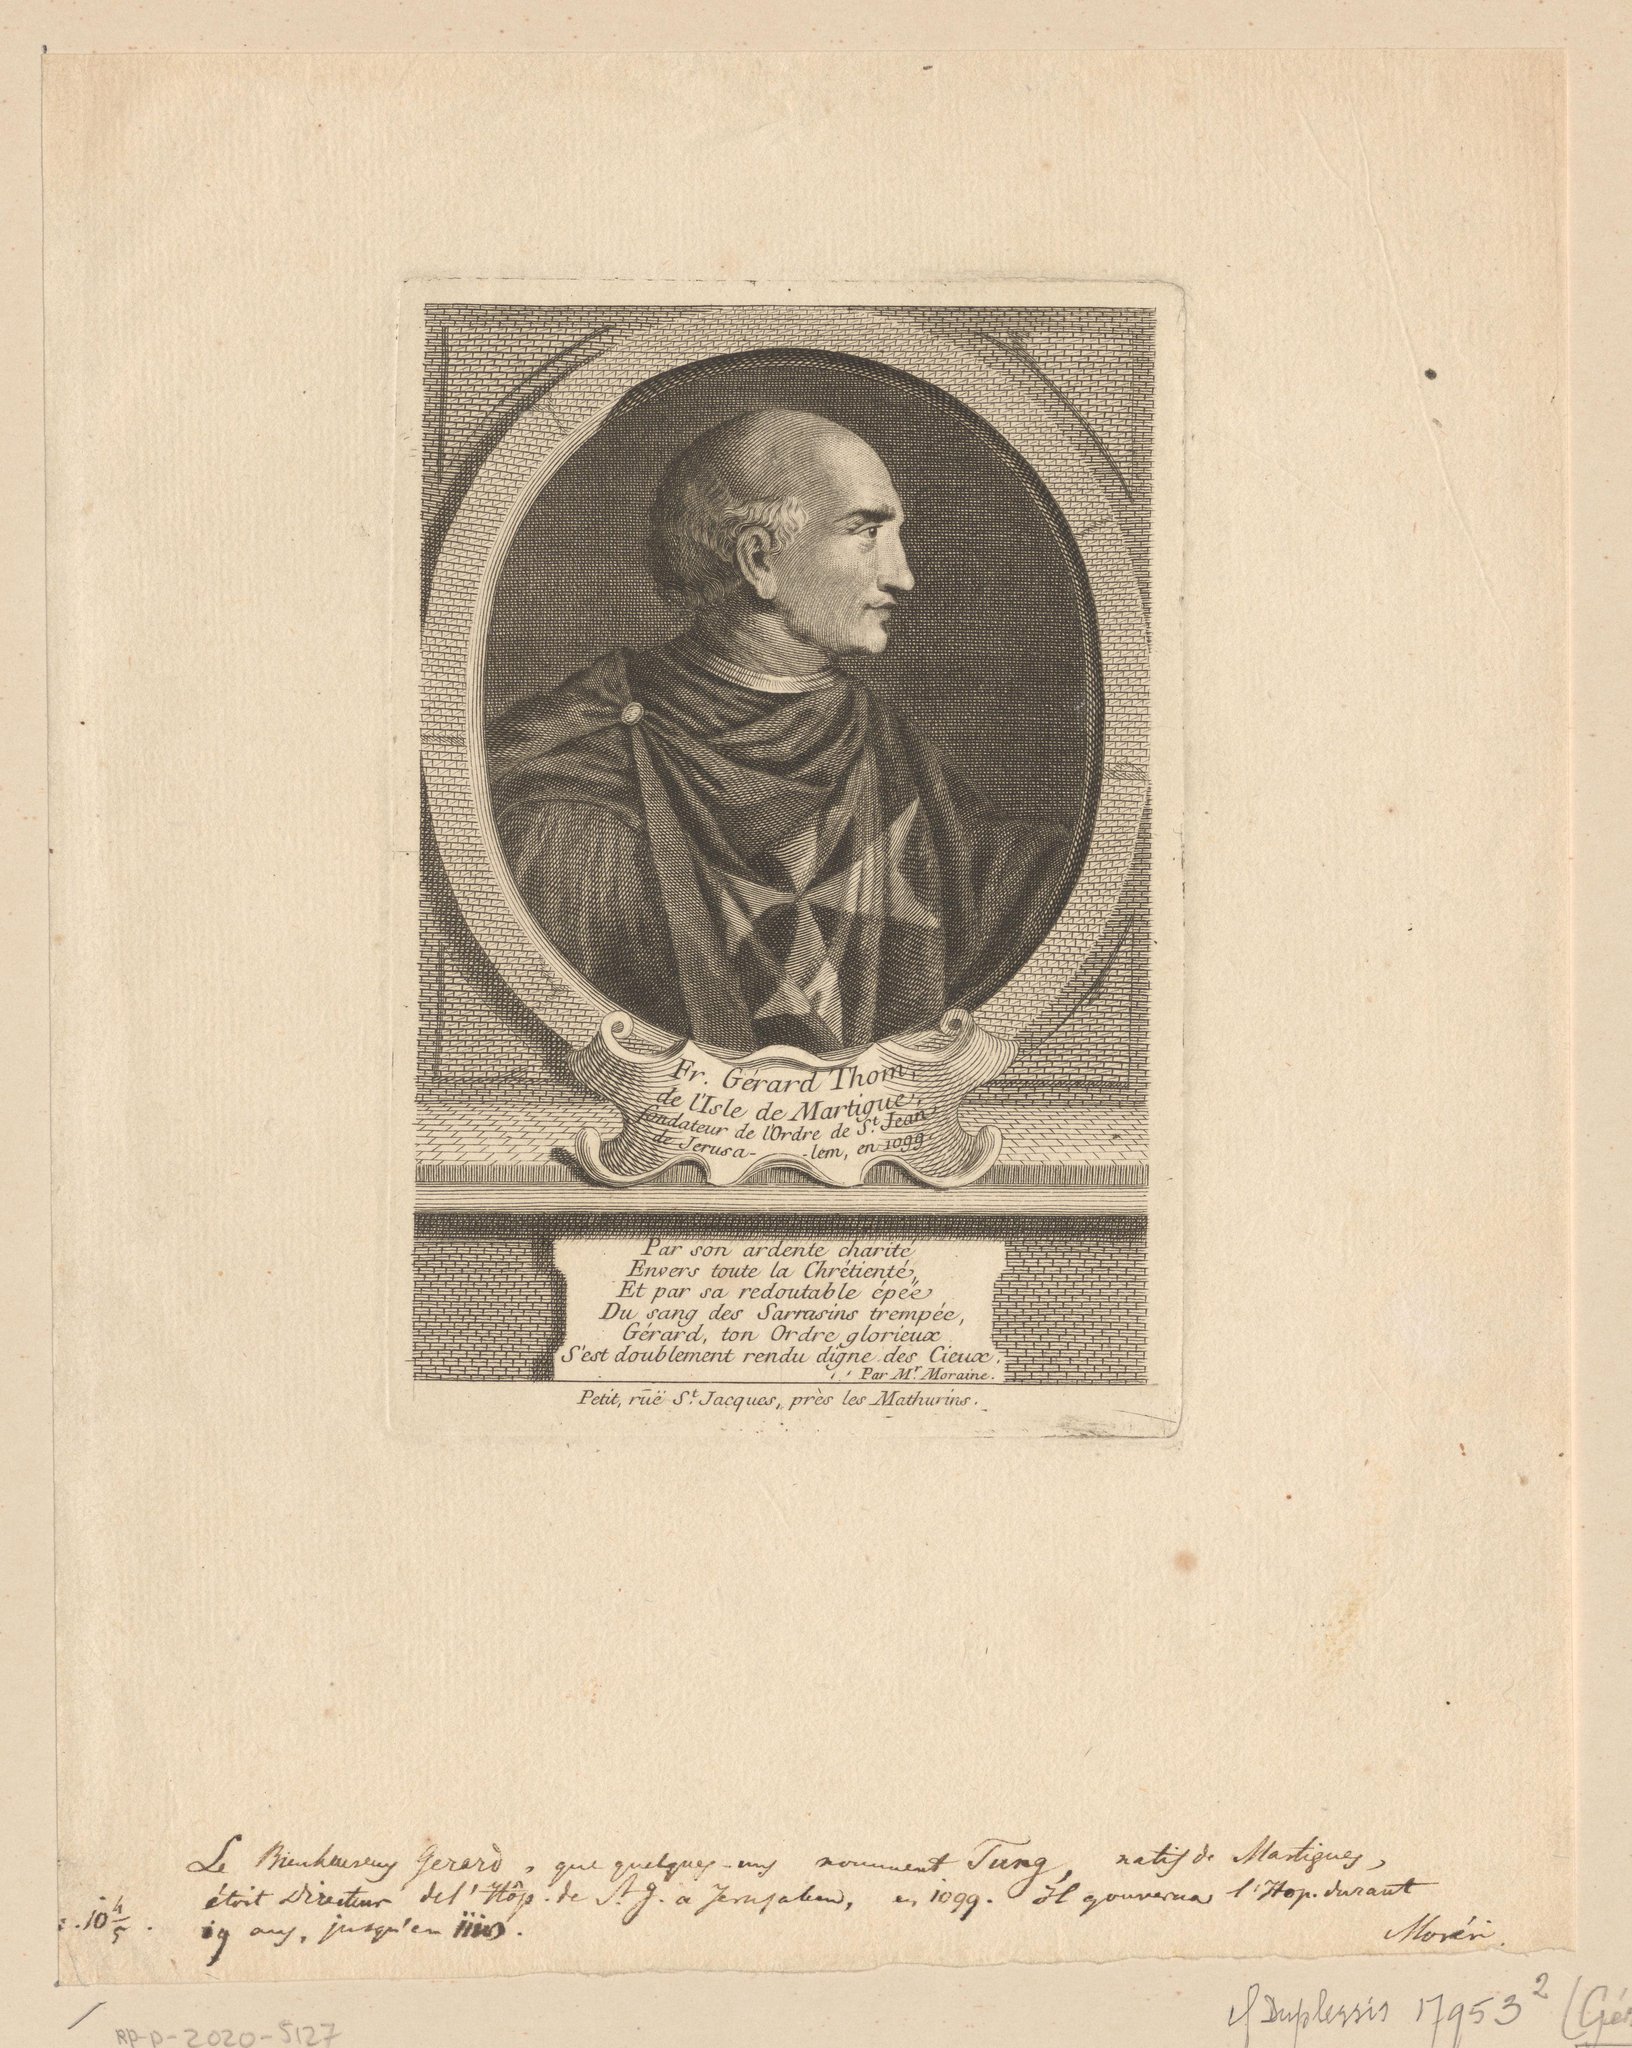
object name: print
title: Portret van Gerard Thom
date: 1729-1742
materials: paper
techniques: engraving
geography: paris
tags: theologian, historical persons